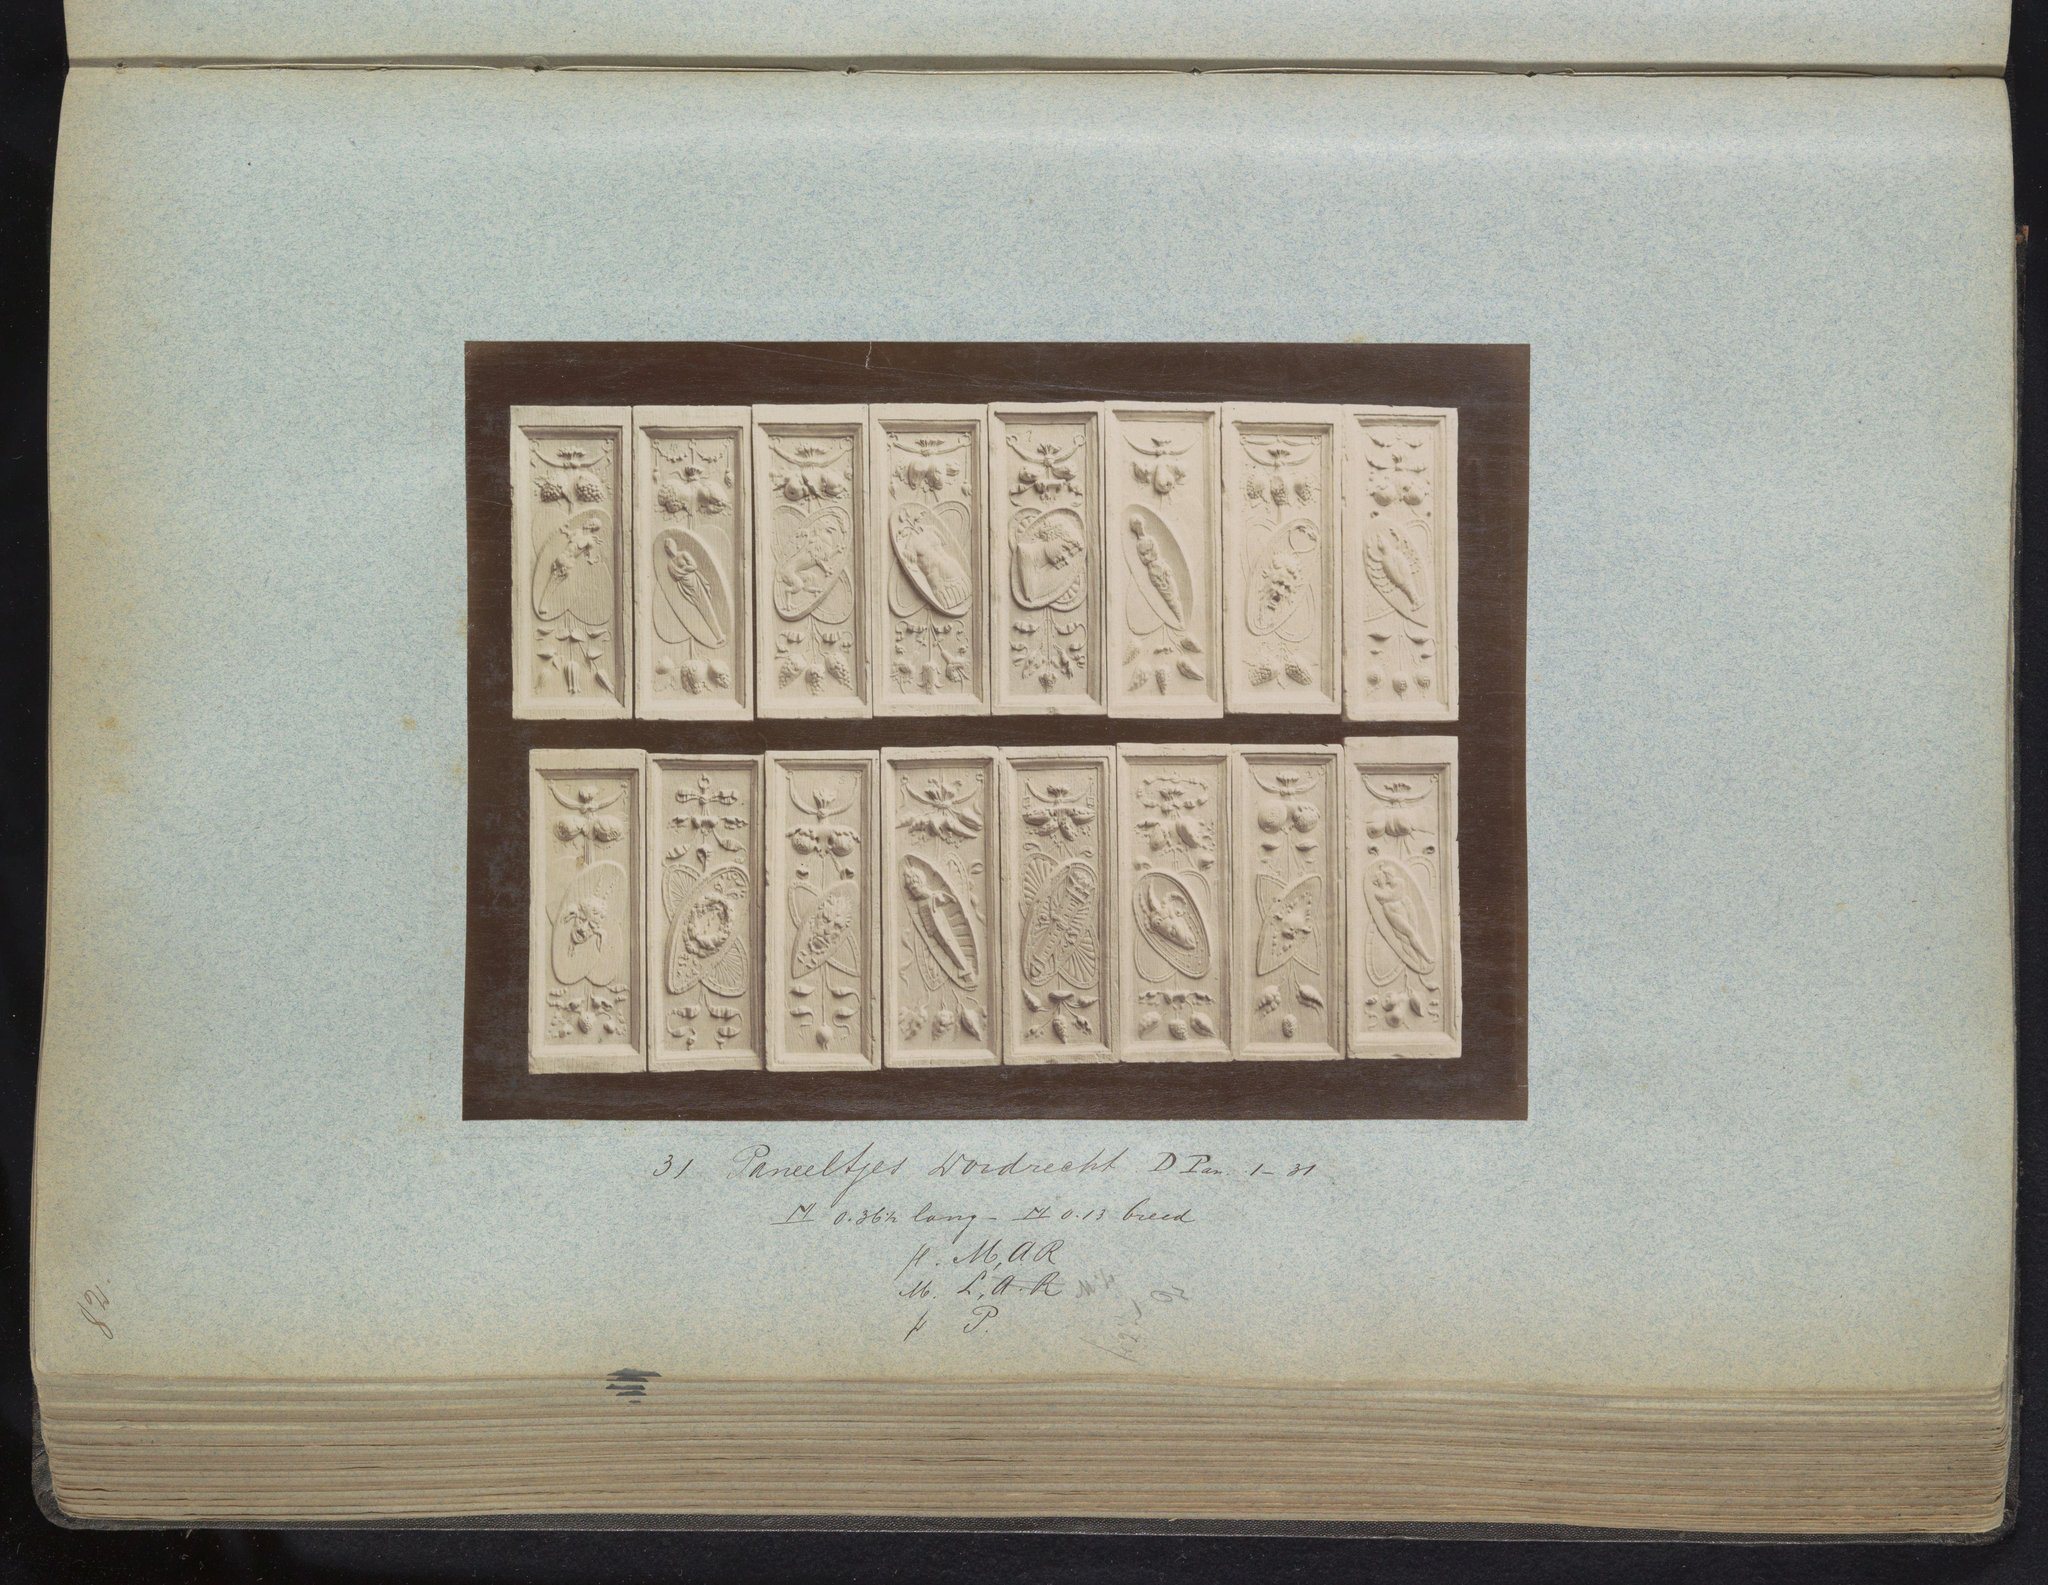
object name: photograph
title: Gipsen afgietsels van paneeltjes uit een kerk te Dordrecht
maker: Anonymous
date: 1875-1900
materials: paper, photographic support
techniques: albumen print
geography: dordrecht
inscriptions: annotation: ‘31 Paneeltjes Dordrecht / M 0.36 1/3 lang - M 0.31 breed’, annotation